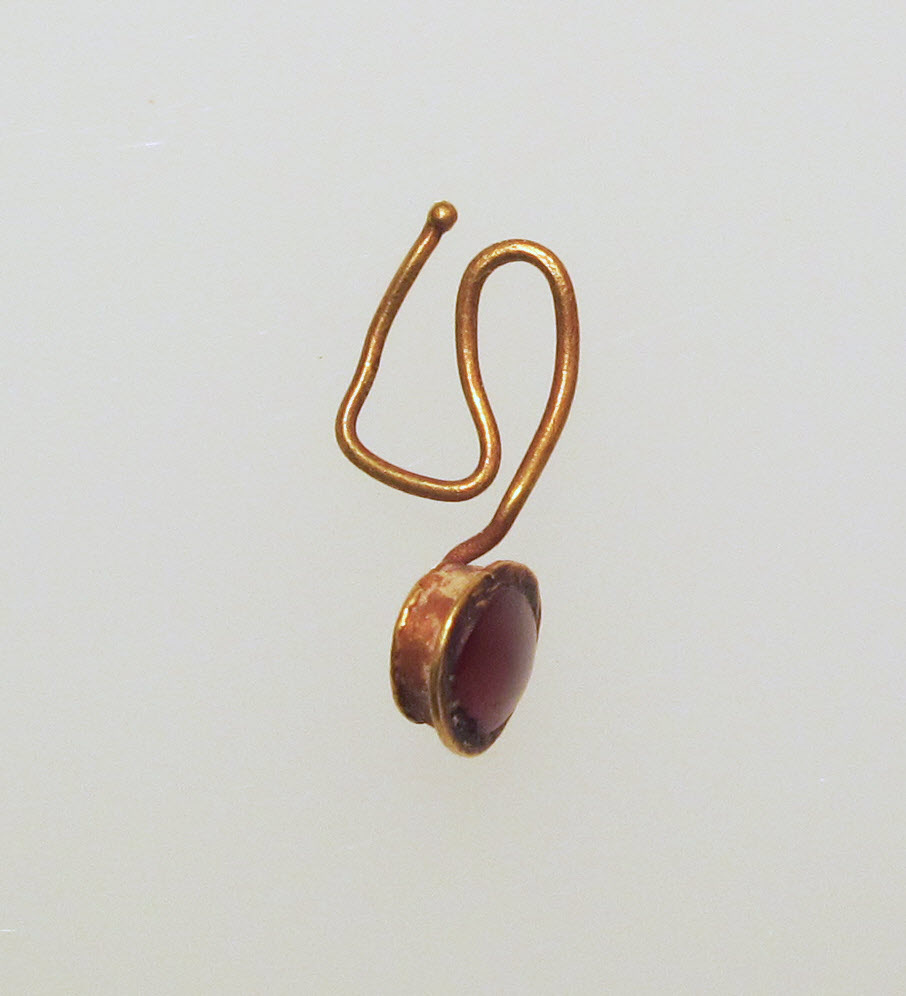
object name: earring hook type with sard setting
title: Earring-hook type with sard setting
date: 7000 BCE-330 CE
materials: gold